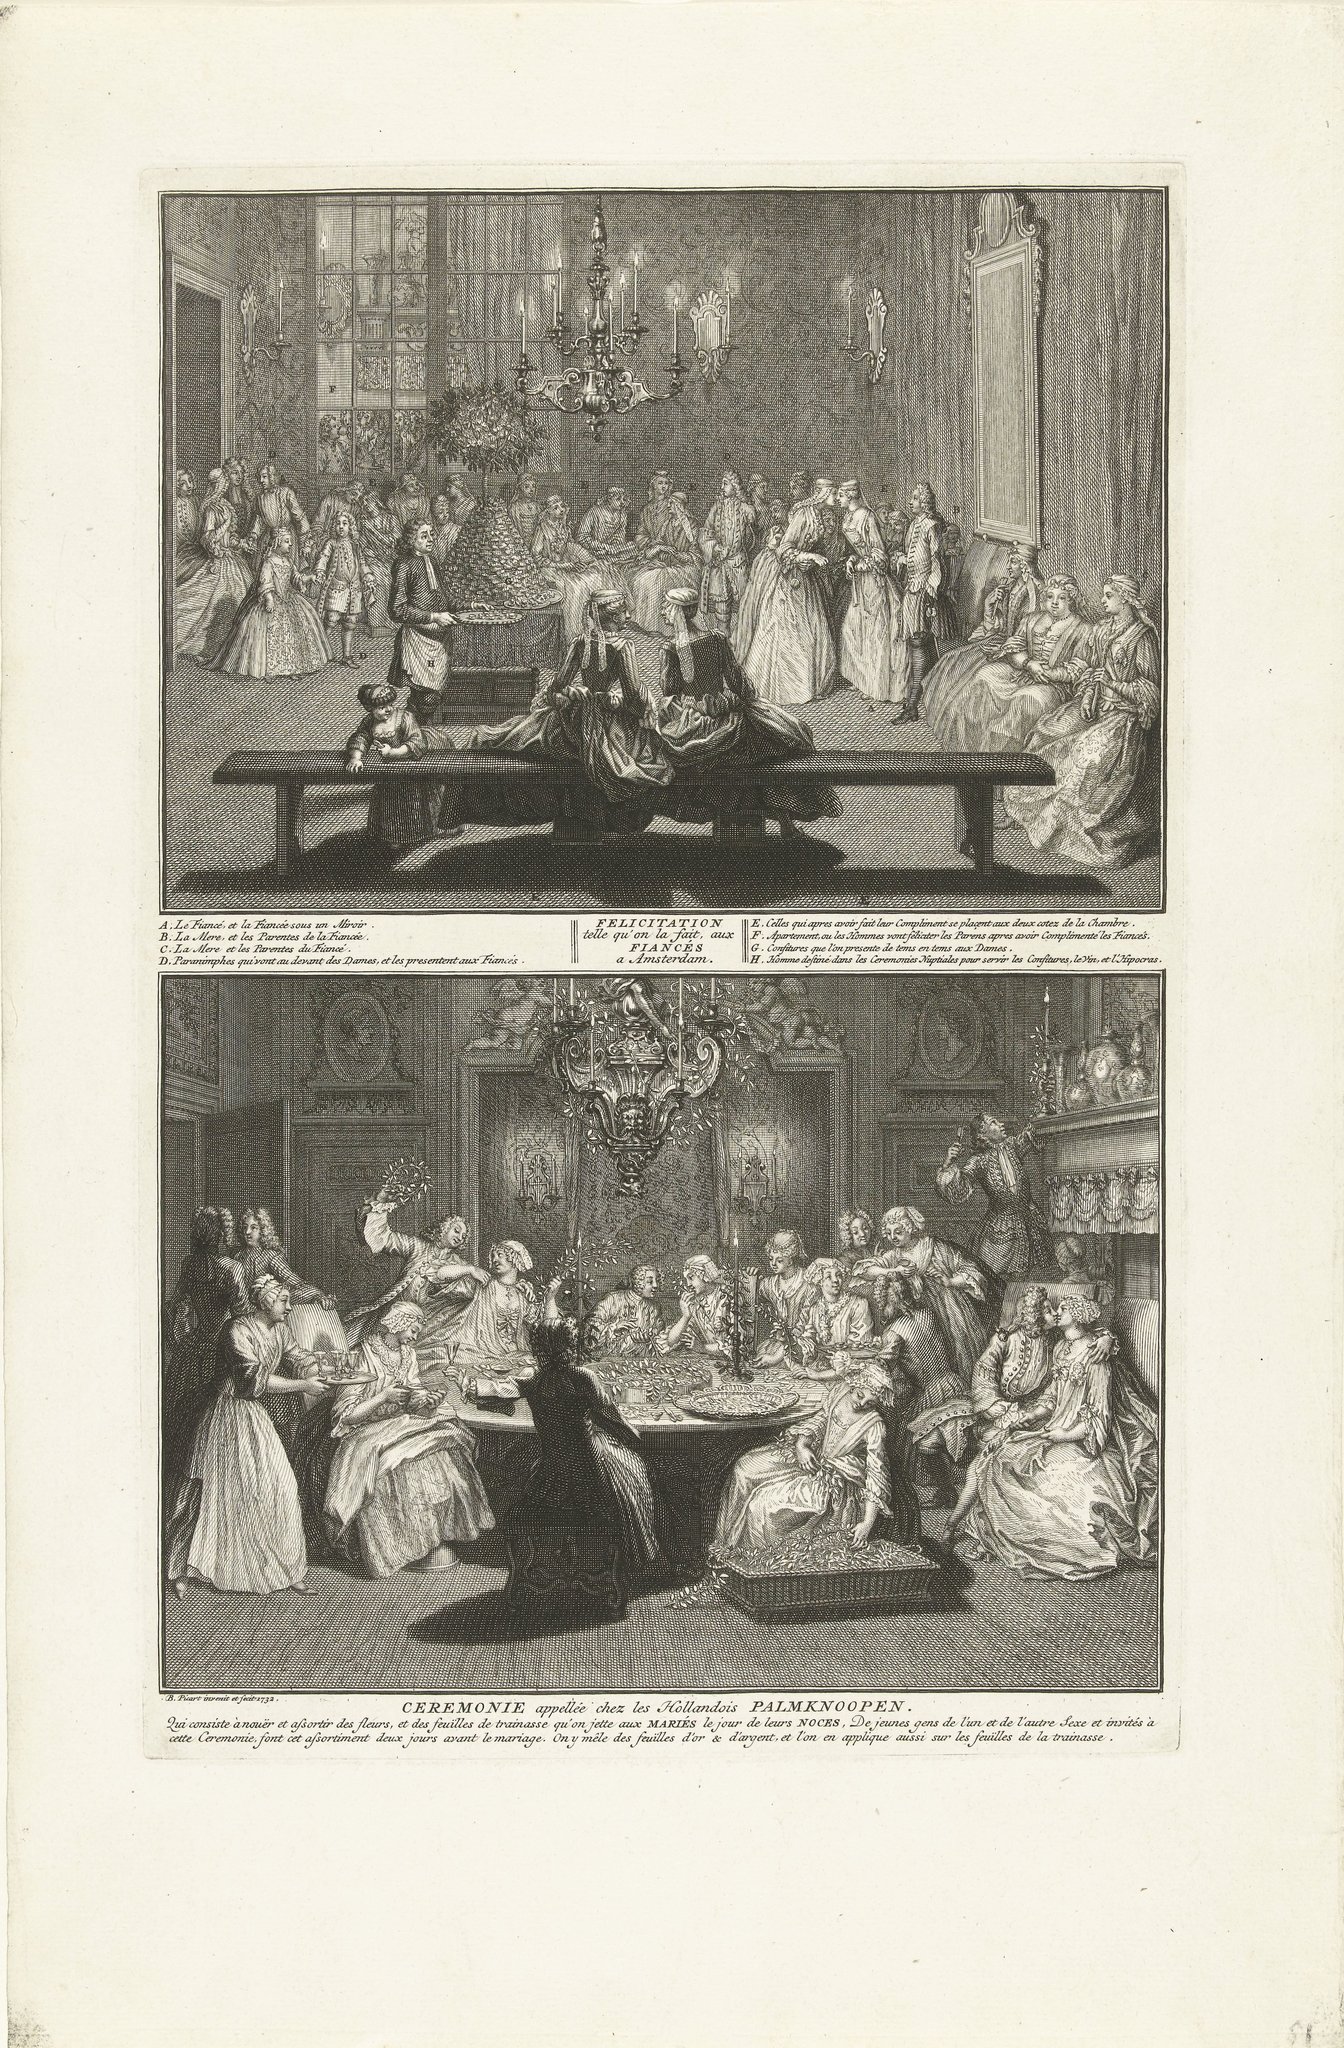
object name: print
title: Felicitation telle qu'on la fait, aux Fiancés a Amsterdam / Ceremonie appellée chez les Hollandois Palmknoopen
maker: bernard picart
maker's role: draughtsman, print maker, publisher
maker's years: 1673-1733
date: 1732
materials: paper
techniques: engraving, etching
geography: northern netherlands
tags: betrothal, amsterdam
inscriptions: collector's mark: Lugt 2228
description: Twee voorstellingen over huwelijksgebruiken bij de hervormden in Amsterdam, ca. 1730. In de bovenste voorstelling neemt het verloofde paar felicitaties en geschenken in ontvangst. In de onderste voorstelling het palmknopen, het knopen van bloemen- en bladerkransen door het verloofde paar en vrienden. Met onderschriften in het Frans.